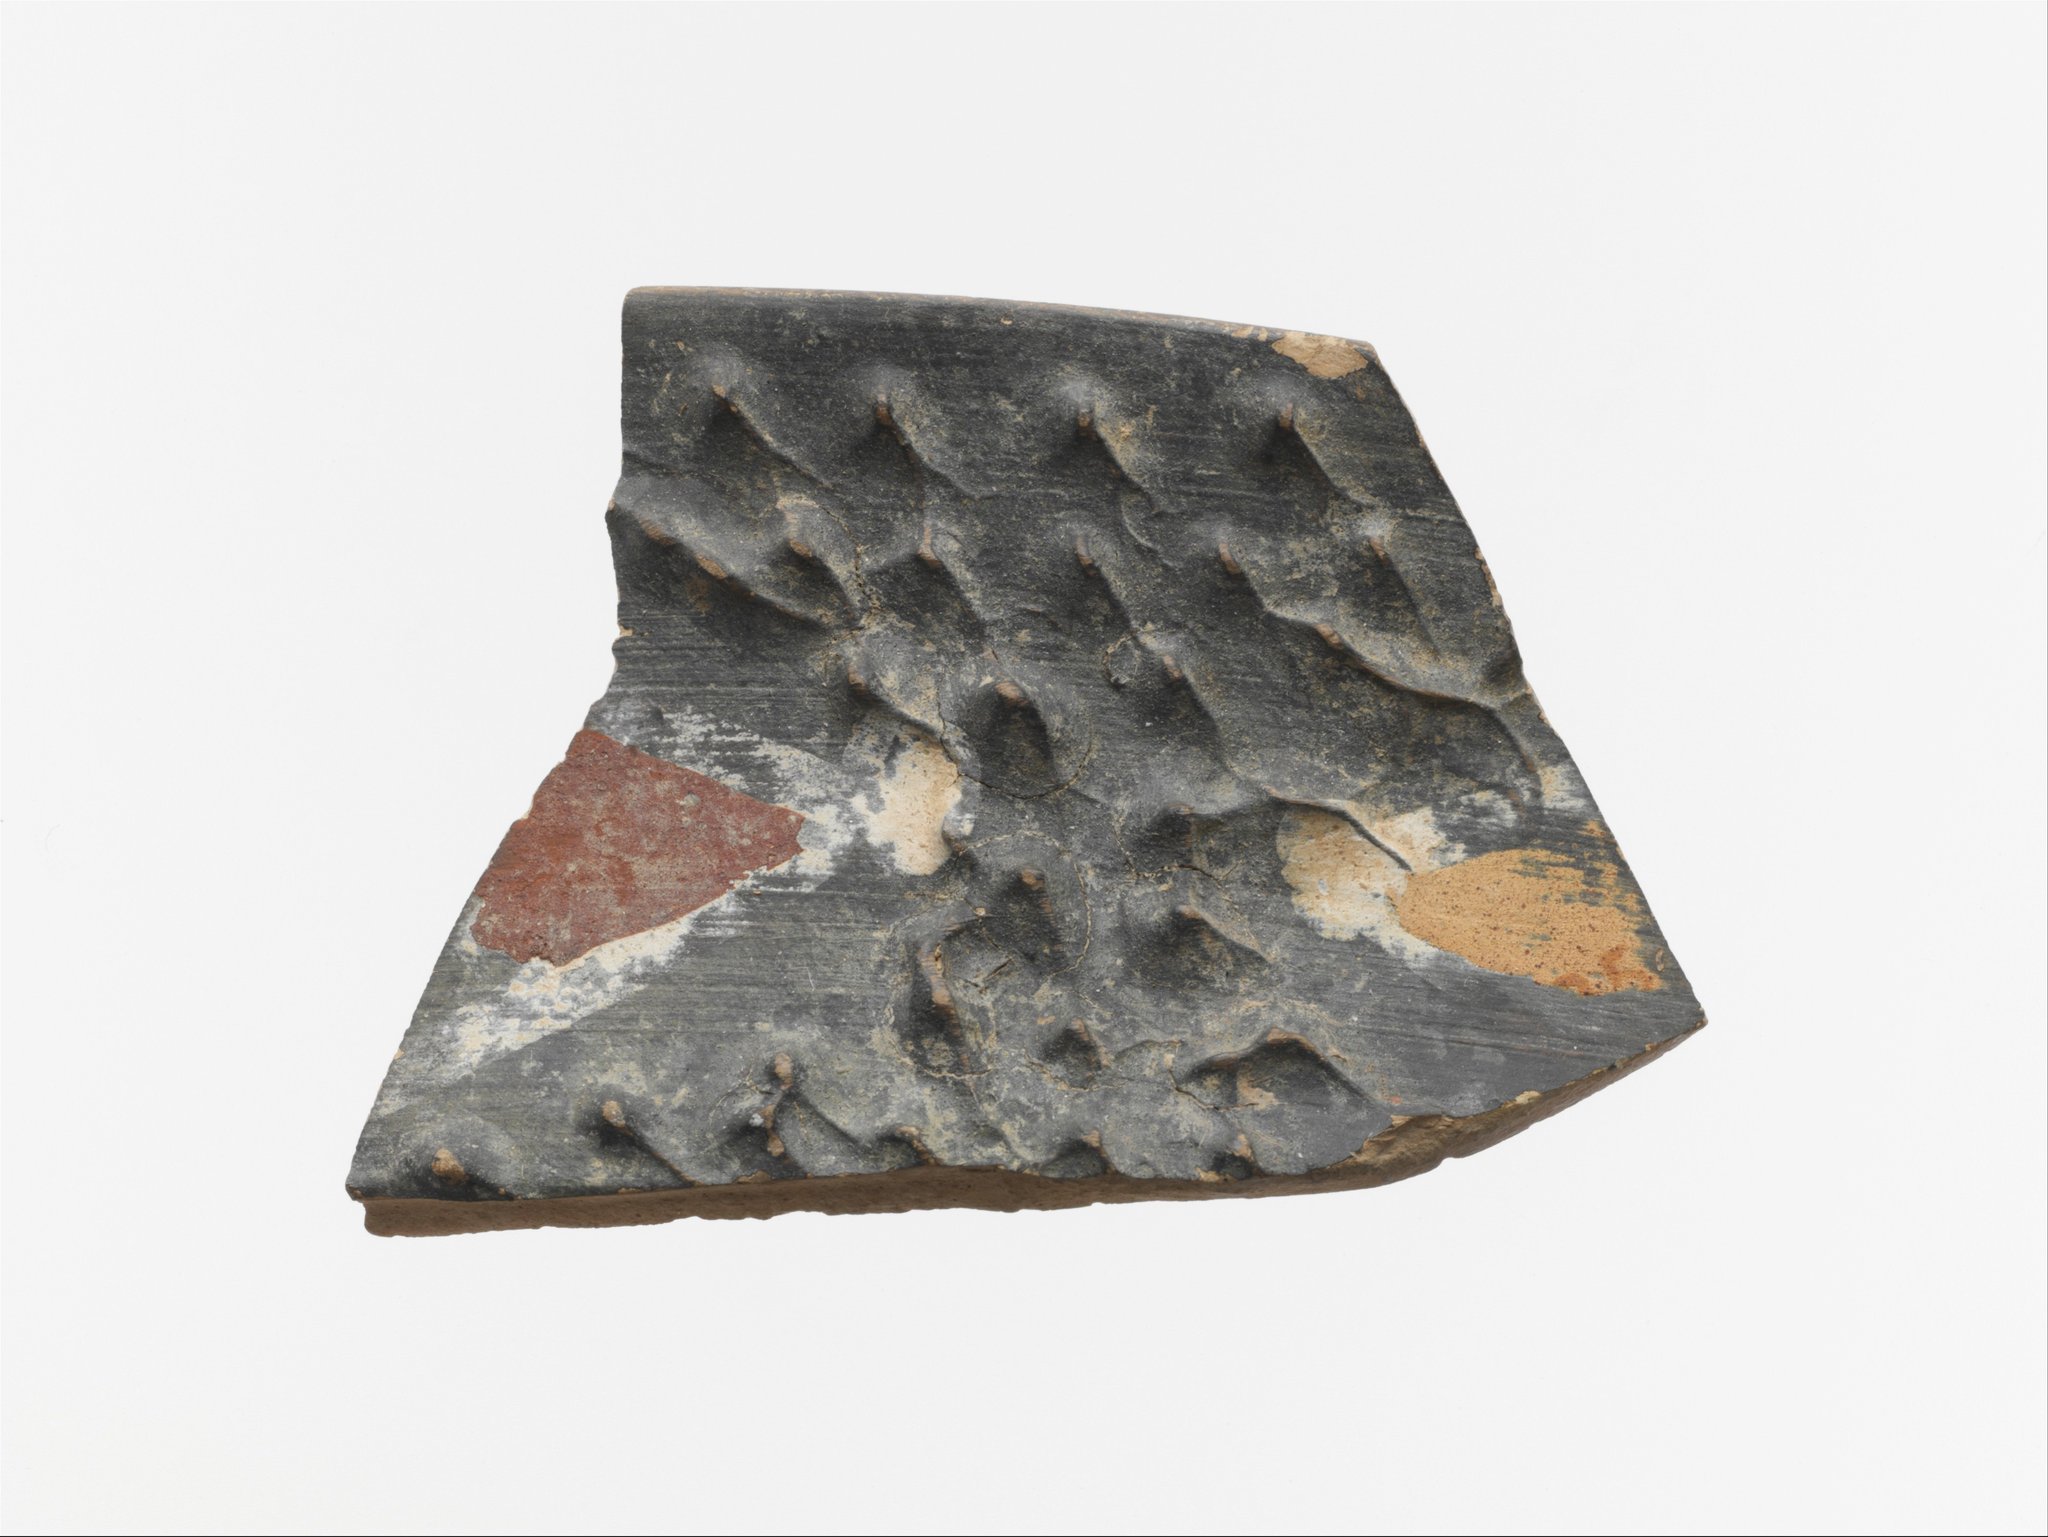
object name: vase fragment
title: Terracotta rim fragment with polychrome decoration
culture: minoan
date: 1800-1700 BCE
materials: terracotta